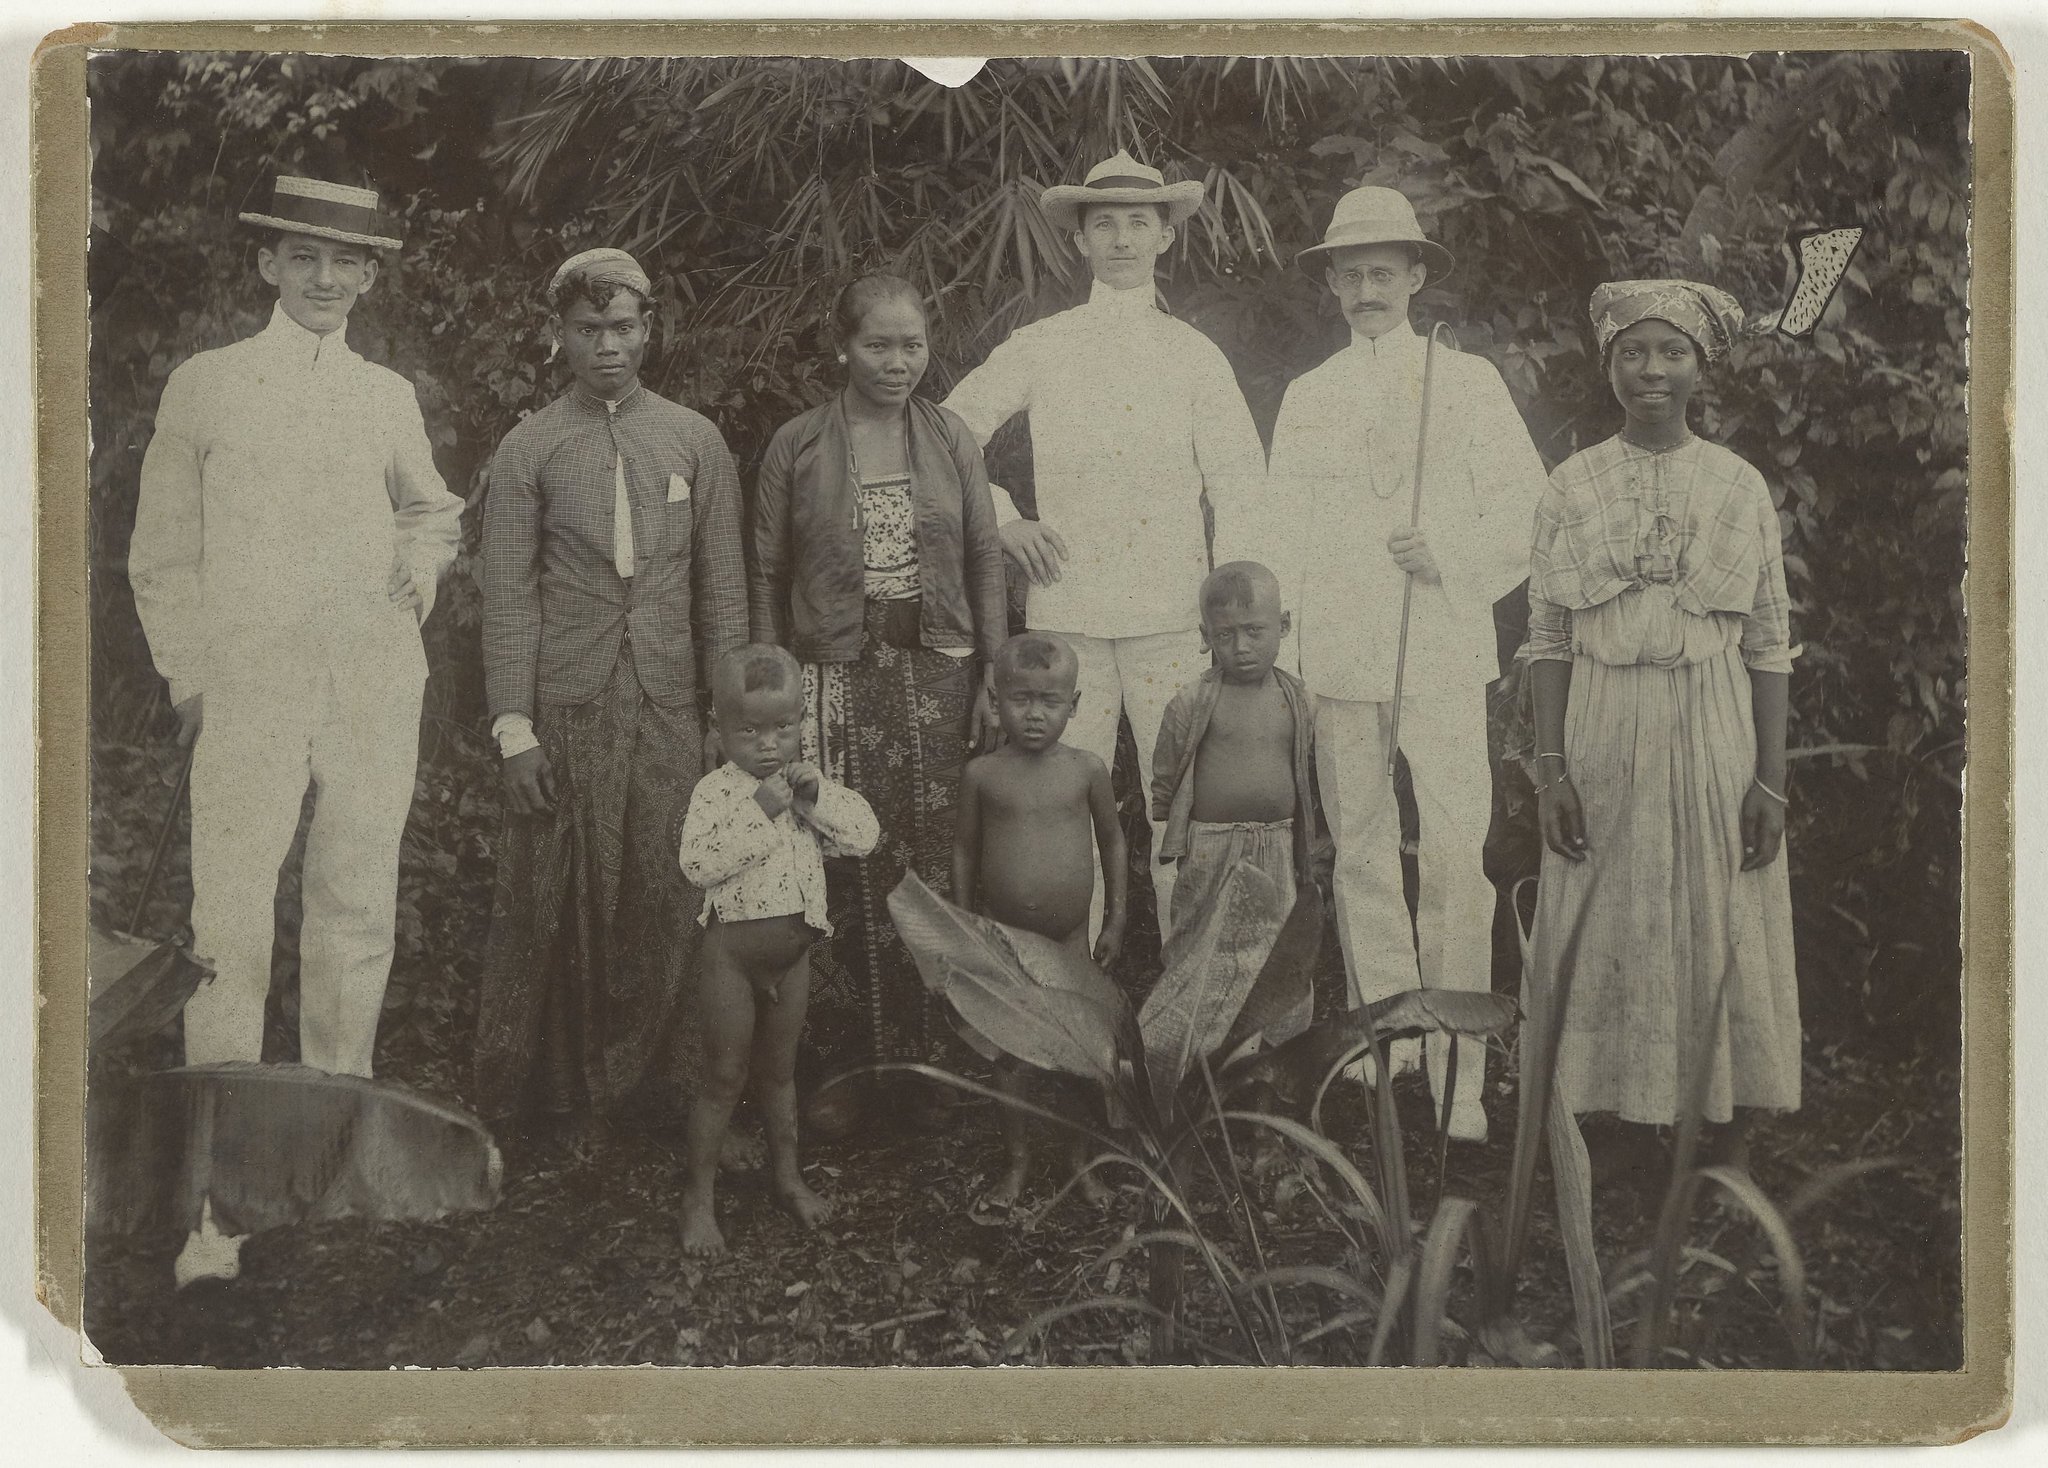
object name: photograph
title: Pa in Suriname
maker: Anonymous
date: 1909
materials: photographic support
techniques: photography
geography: suriname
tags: historical persons not known by name - bb - woman, historical persons not known by name, suriname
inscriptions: inscription: ‘Pa in Suriname, Javanen’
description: Foto met zes volwassenen en drie kinderen tussen bananenplanten in Suriname. Het gezelschap bestaat uit drie blanke volwassen mannen, vermoedelijk Nederlanders, een Javaans gezin, bestaande uit een man en een vrouw en drie kleine kinderen, en een Creoolse vrouw. Op de achterkant een opschrift.